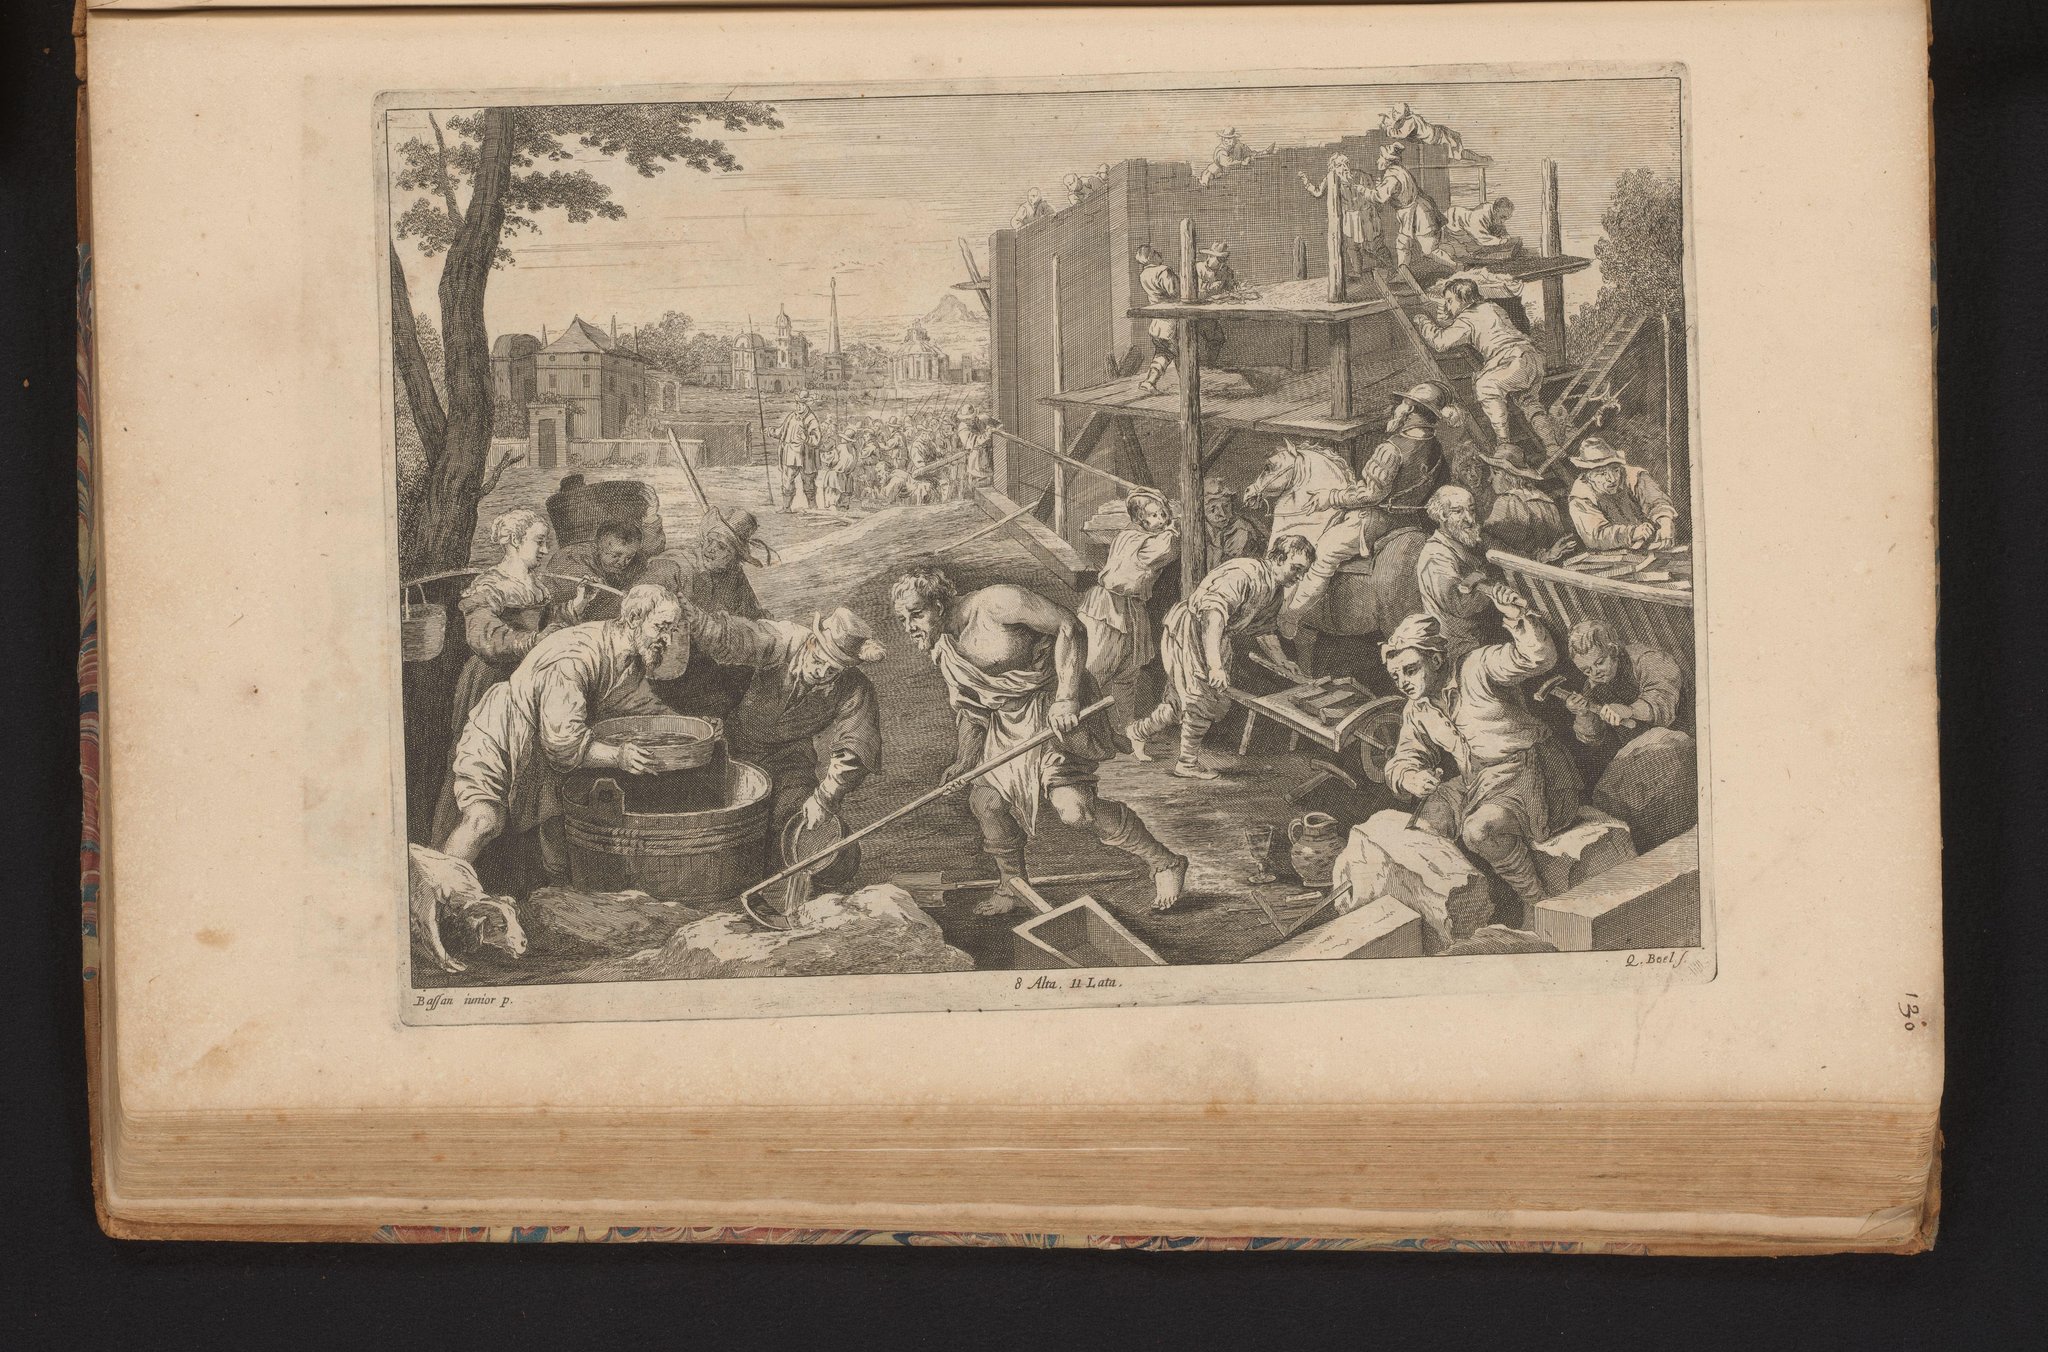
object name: album leaf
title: Bouw van de Toren van Babel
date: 1660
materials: paper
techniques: etching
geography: brussels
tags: the building of the tower of babel; nimrod may be present, supervising or assisting the construction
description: De prent is vervaardigd naar het schilderij van Bassano dat zich in de collectie van The National Gallery te Londen bevindt (inventarisnummer NG60). David Teniers heeft waarschijnlijk van alle schilderijen uit de collectie van Leopold Willem van Oostenrijk een olieverfstudie op doek of paneel vervaardigd (zgn. pasticcio), die als voorbeeld voor de prentmakers diende. Het is niet altijd duidelijk of de pasticci door hem zijn gemaakt of door zijn atelier. Niet alle pasticci zijn overgeleverd.